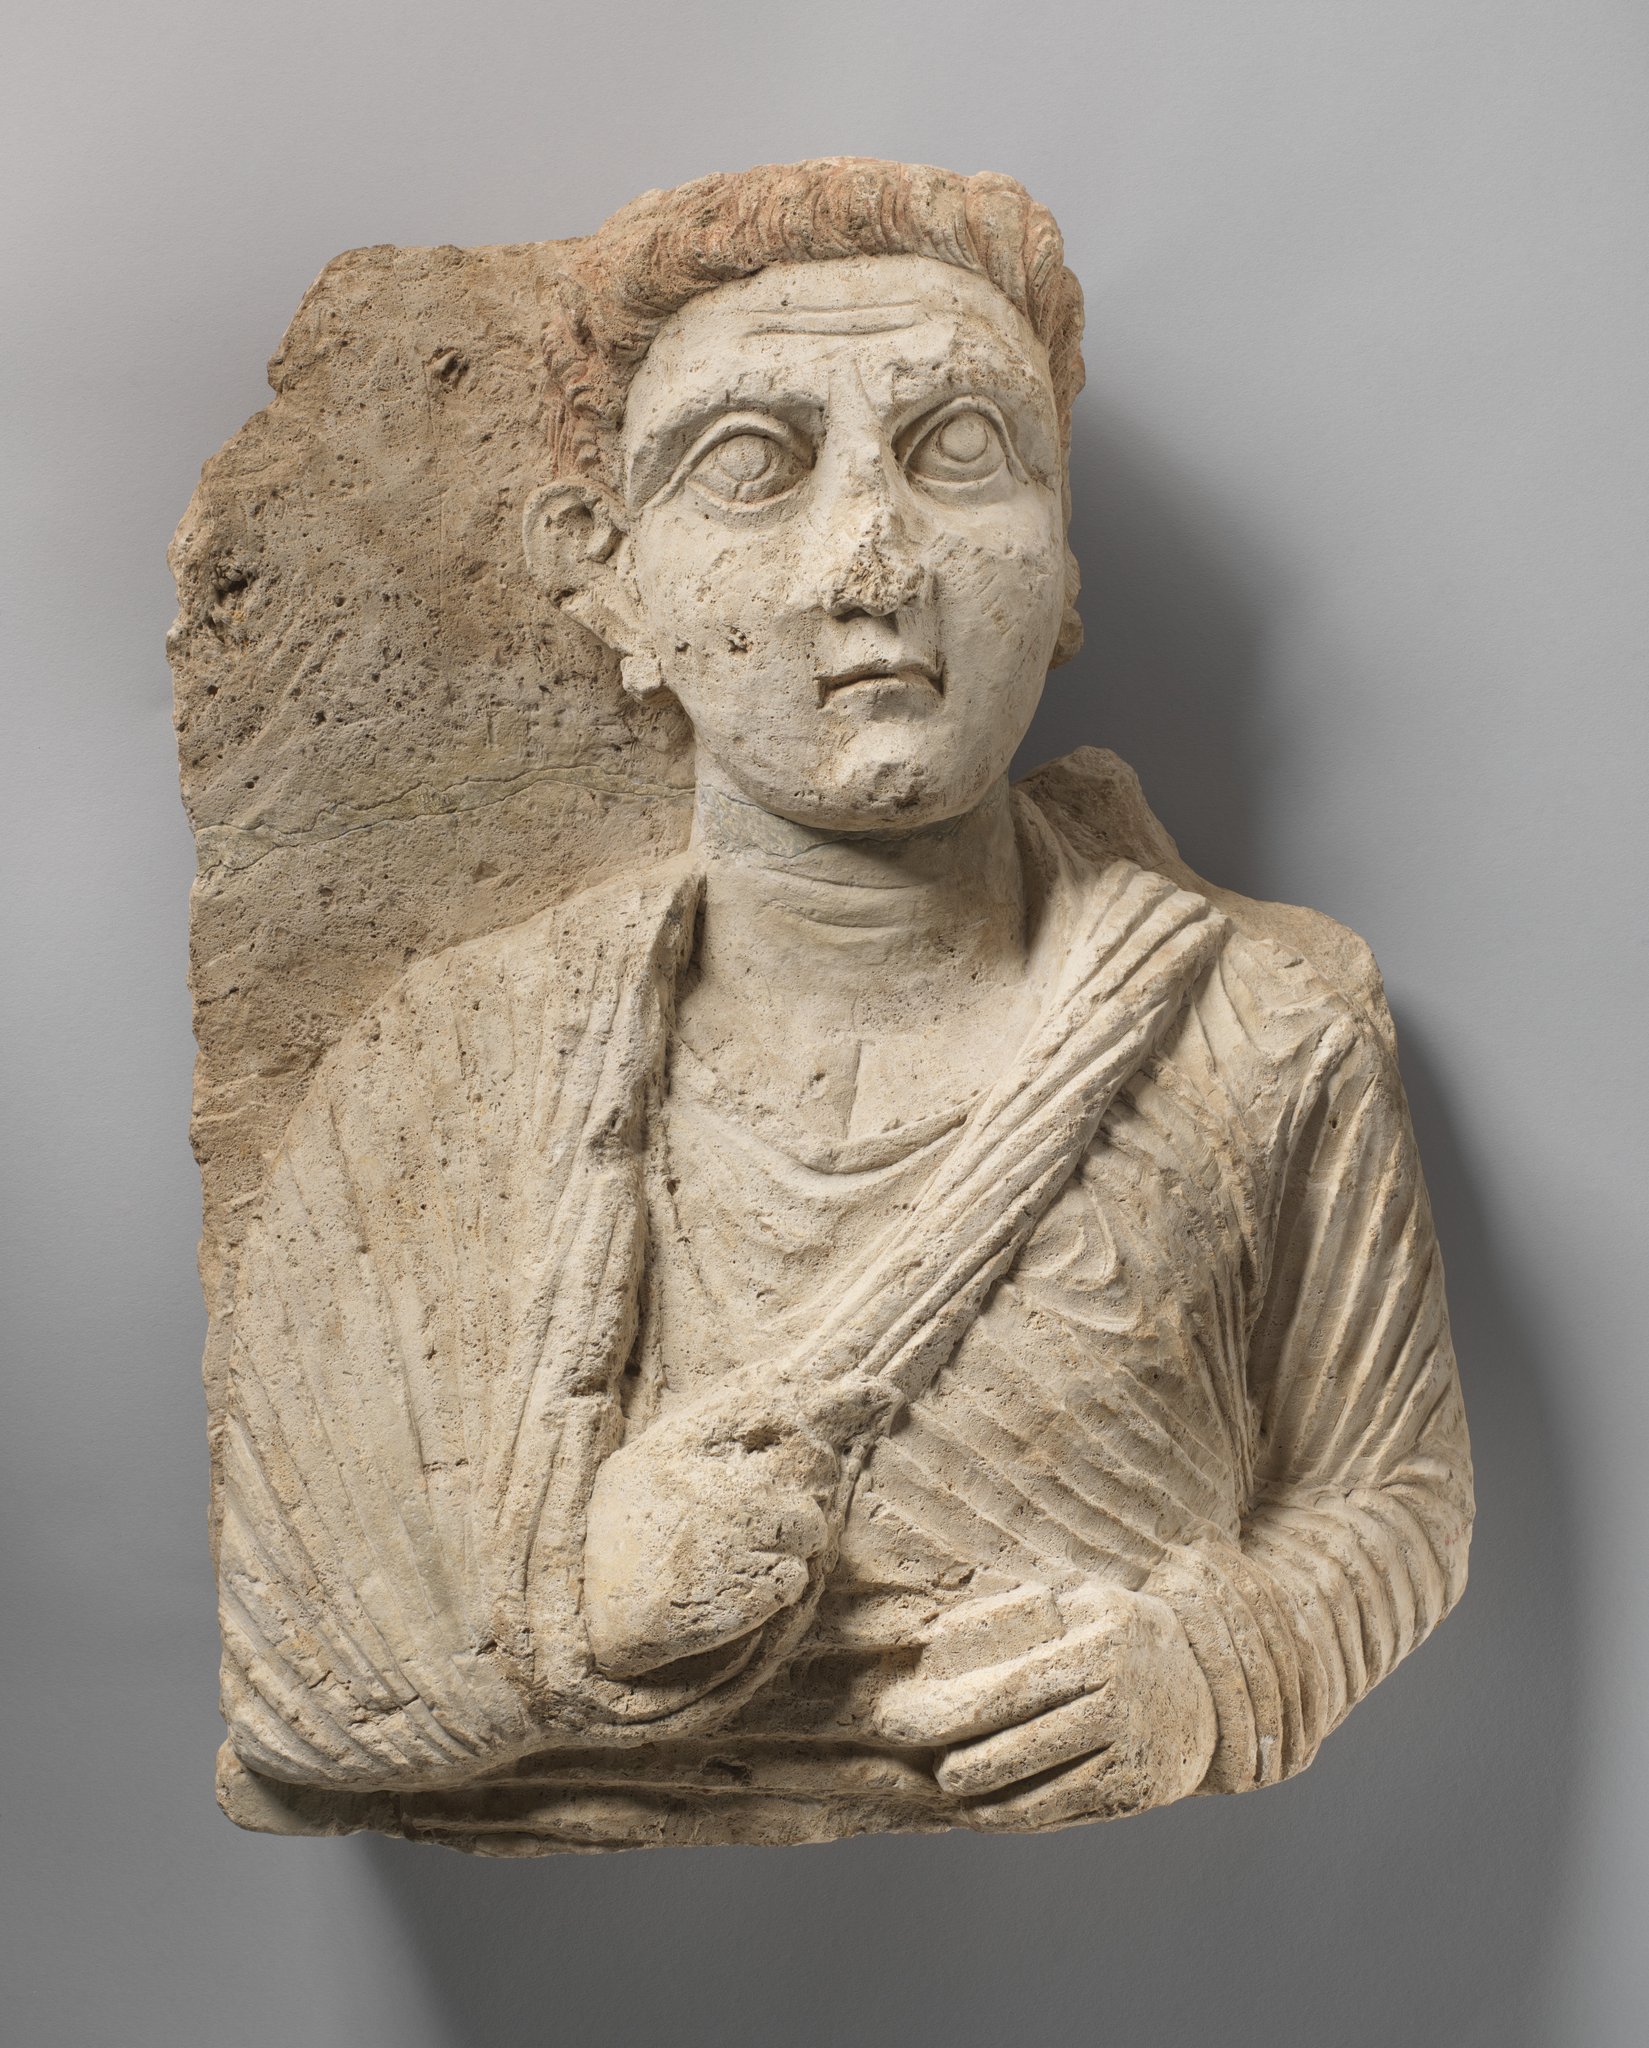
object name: funerary relief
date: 125-150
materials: limestone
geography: syria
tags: men